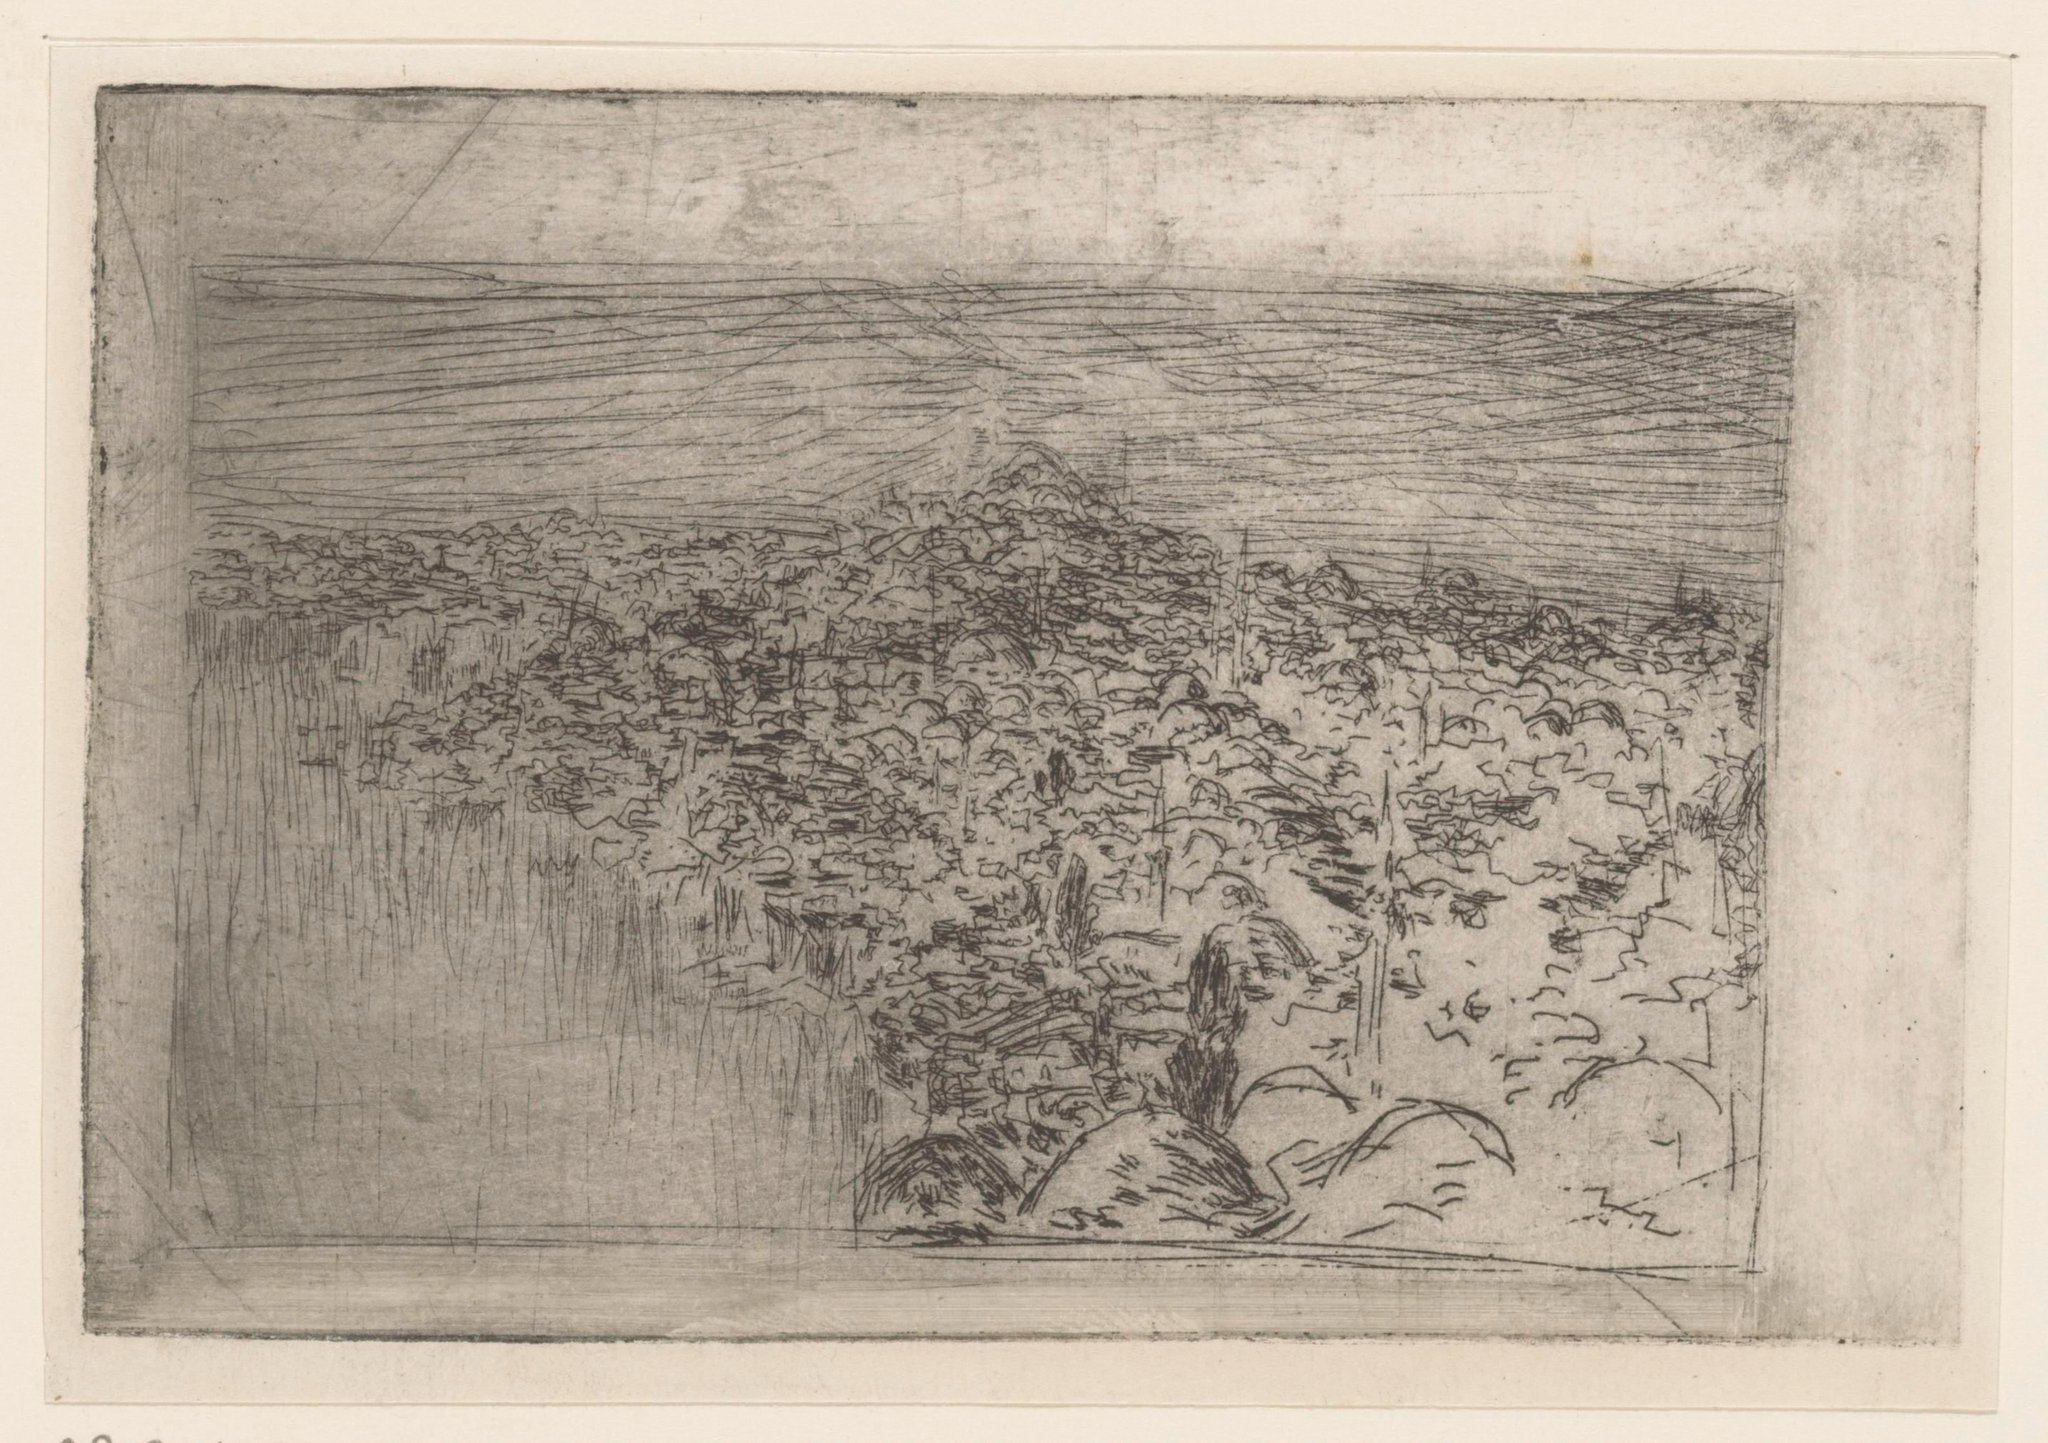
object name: print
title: Stadsgezicht op Constantinopel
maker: marius bauer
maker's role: draughtsman, print maker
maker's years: 1867-1932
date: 1889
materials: paper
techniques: etching, intaglio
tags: city-view in general; 'veduta'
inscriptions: collector's mark: Lugt 2228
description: Een stadsgezicht op Constantinopel met verschillende moskeeën. Links water.